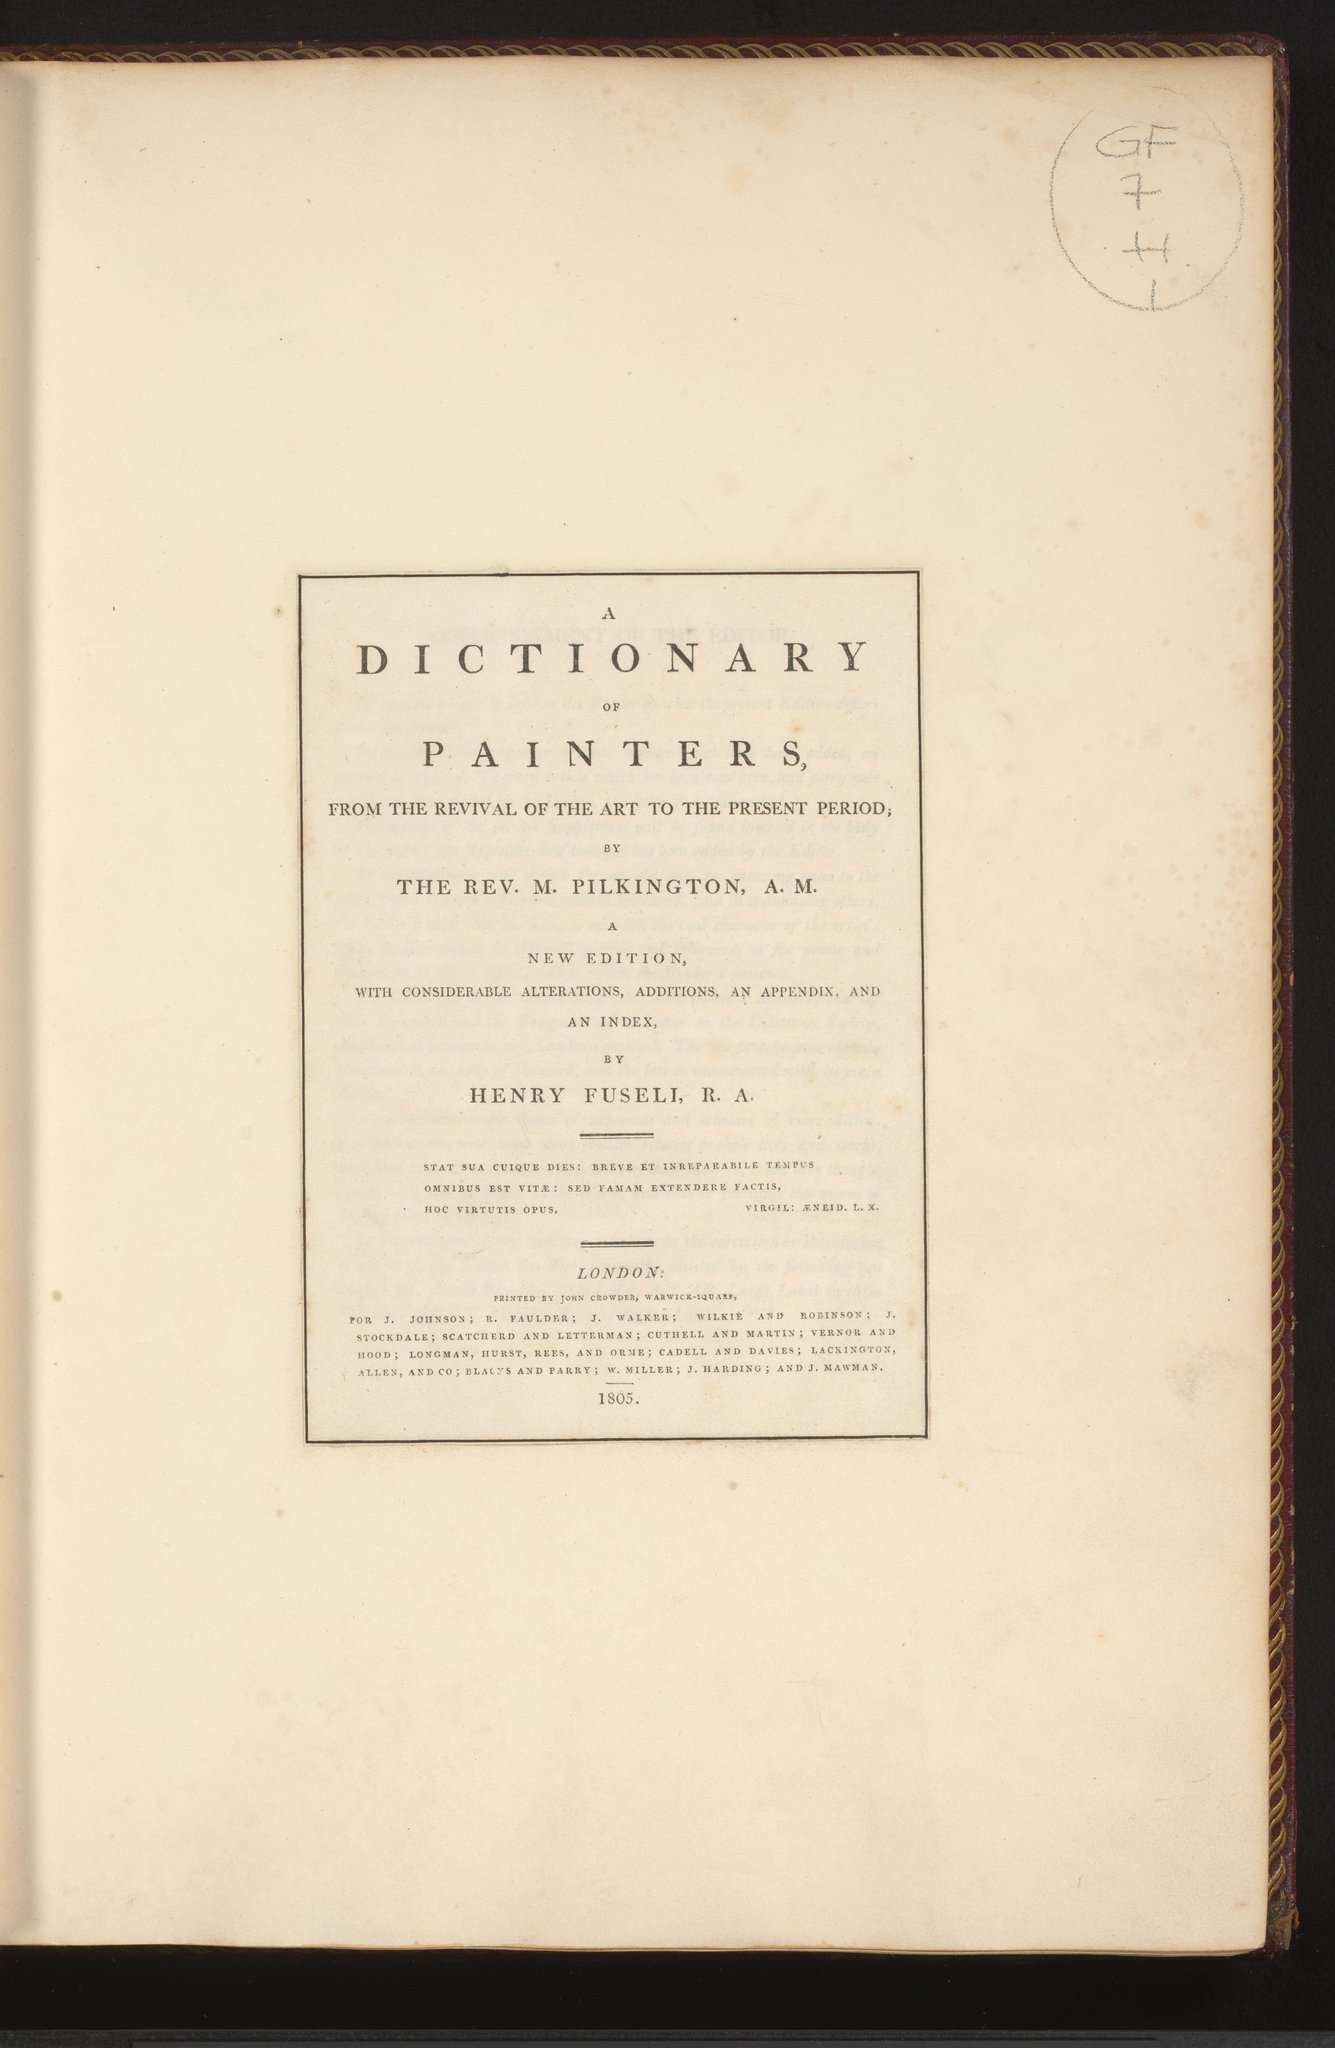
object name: titelblad, titelpagina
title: A Dictionary of Painters, from the revival of the art to the present period, by the rev. M. Pilkington, A.M. A New Edition, with considerable alterations, additions, an appendix, and an index, by Henry Fuseli, R.A.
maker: john p. crowder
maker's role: printer, publisher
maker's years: 1787-1830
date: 1805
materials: paper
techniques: letterpress printing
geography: london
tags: title-page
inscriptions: inscription: ‘GF/ 7/ H/ 1’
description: Titelpagina voor: Pilkington, Matthew en Johann Heinrich Füssli. A dictionary of painters, from the revival of the art to the present period. 4 dln. Londen: John Crowder, 1805.